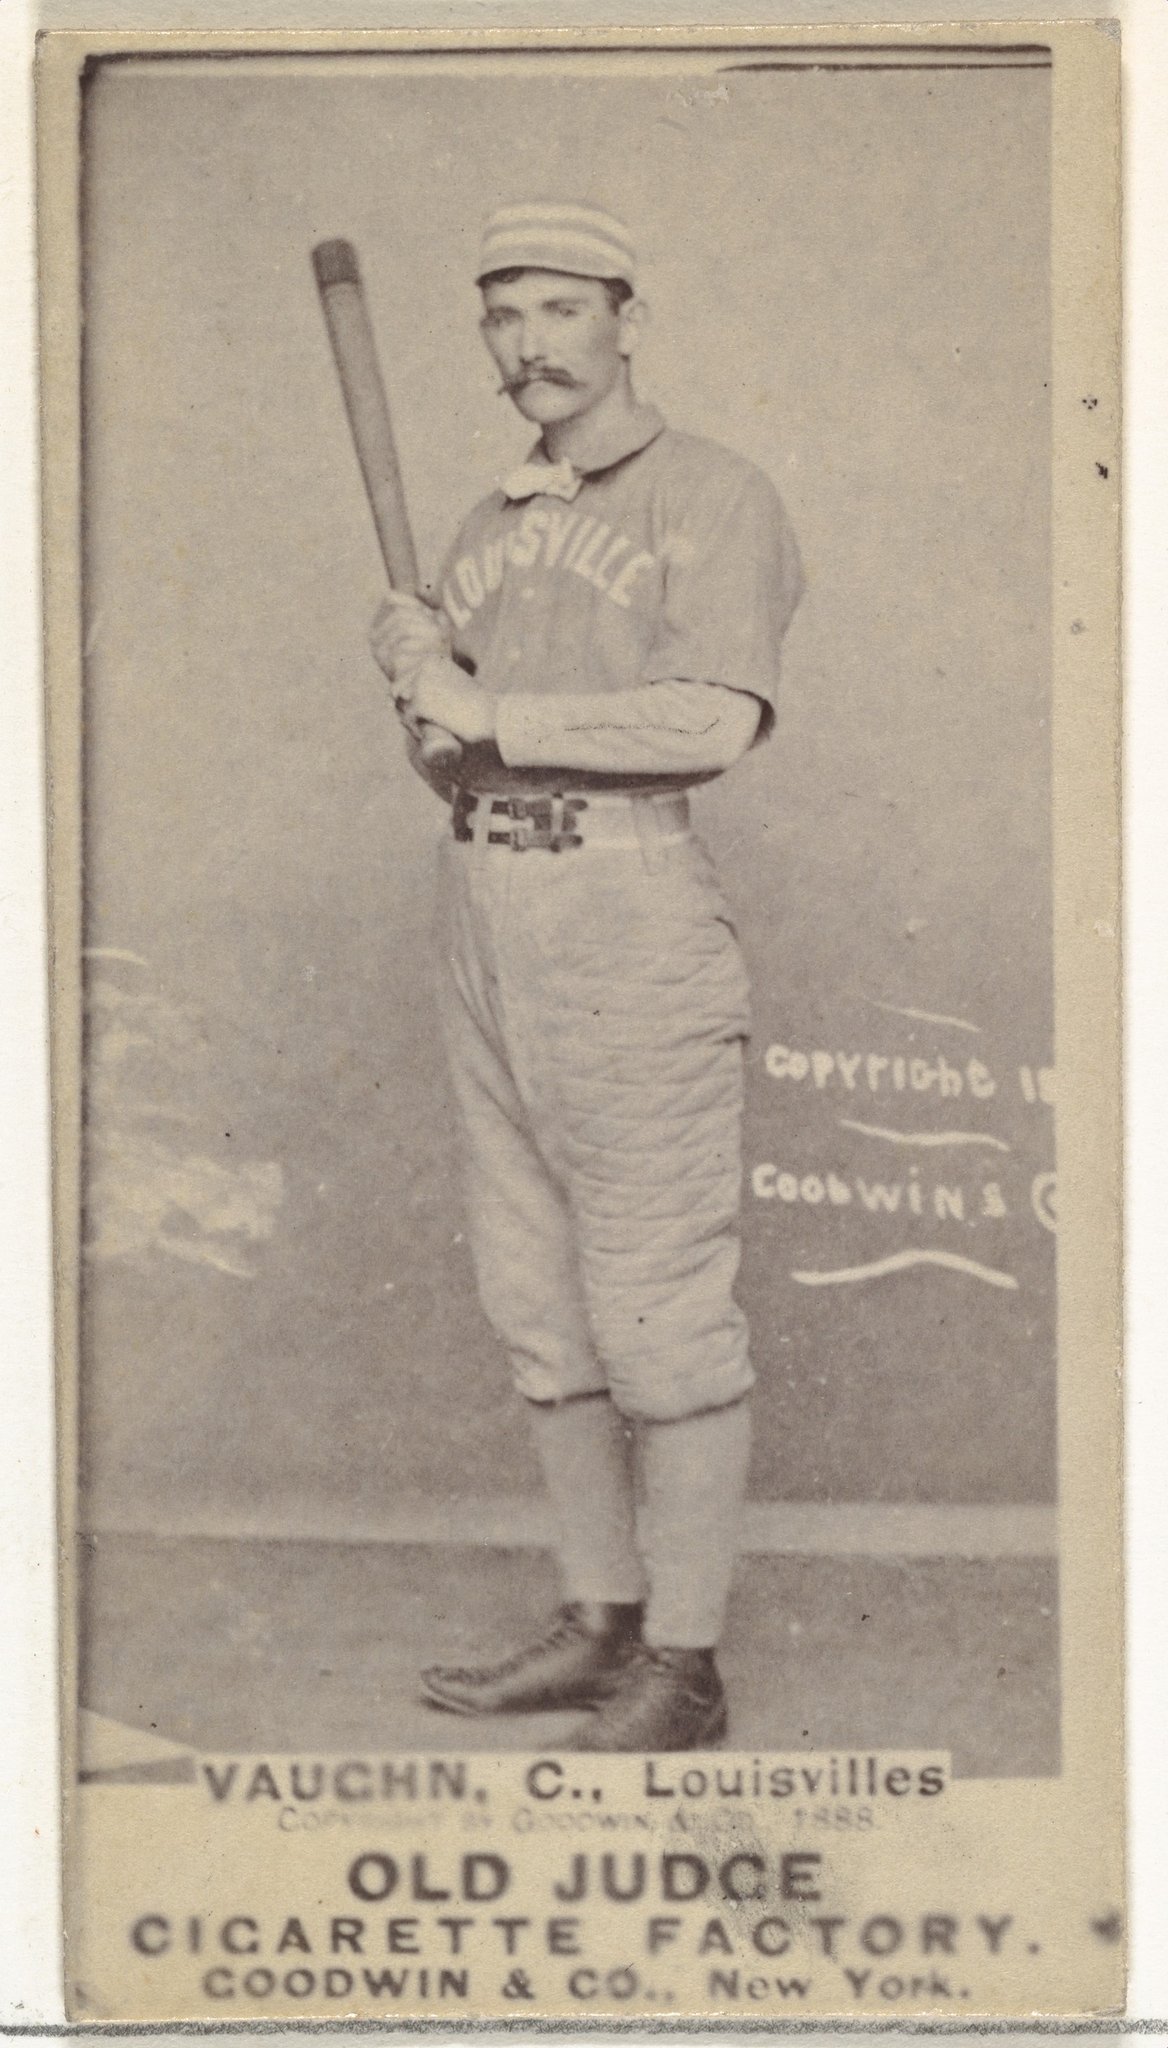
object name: baseball card, photograph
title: Harry Francis "Farmer" Vaughn, Catcher, Louisville Colonels, from the Old Judge series (N172) for Old Judge Cigarettes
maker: goodwin & company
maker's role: publisher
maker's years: 1850-1950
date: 1888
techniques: albumen silver print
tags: men,portraits,baseball,athletes